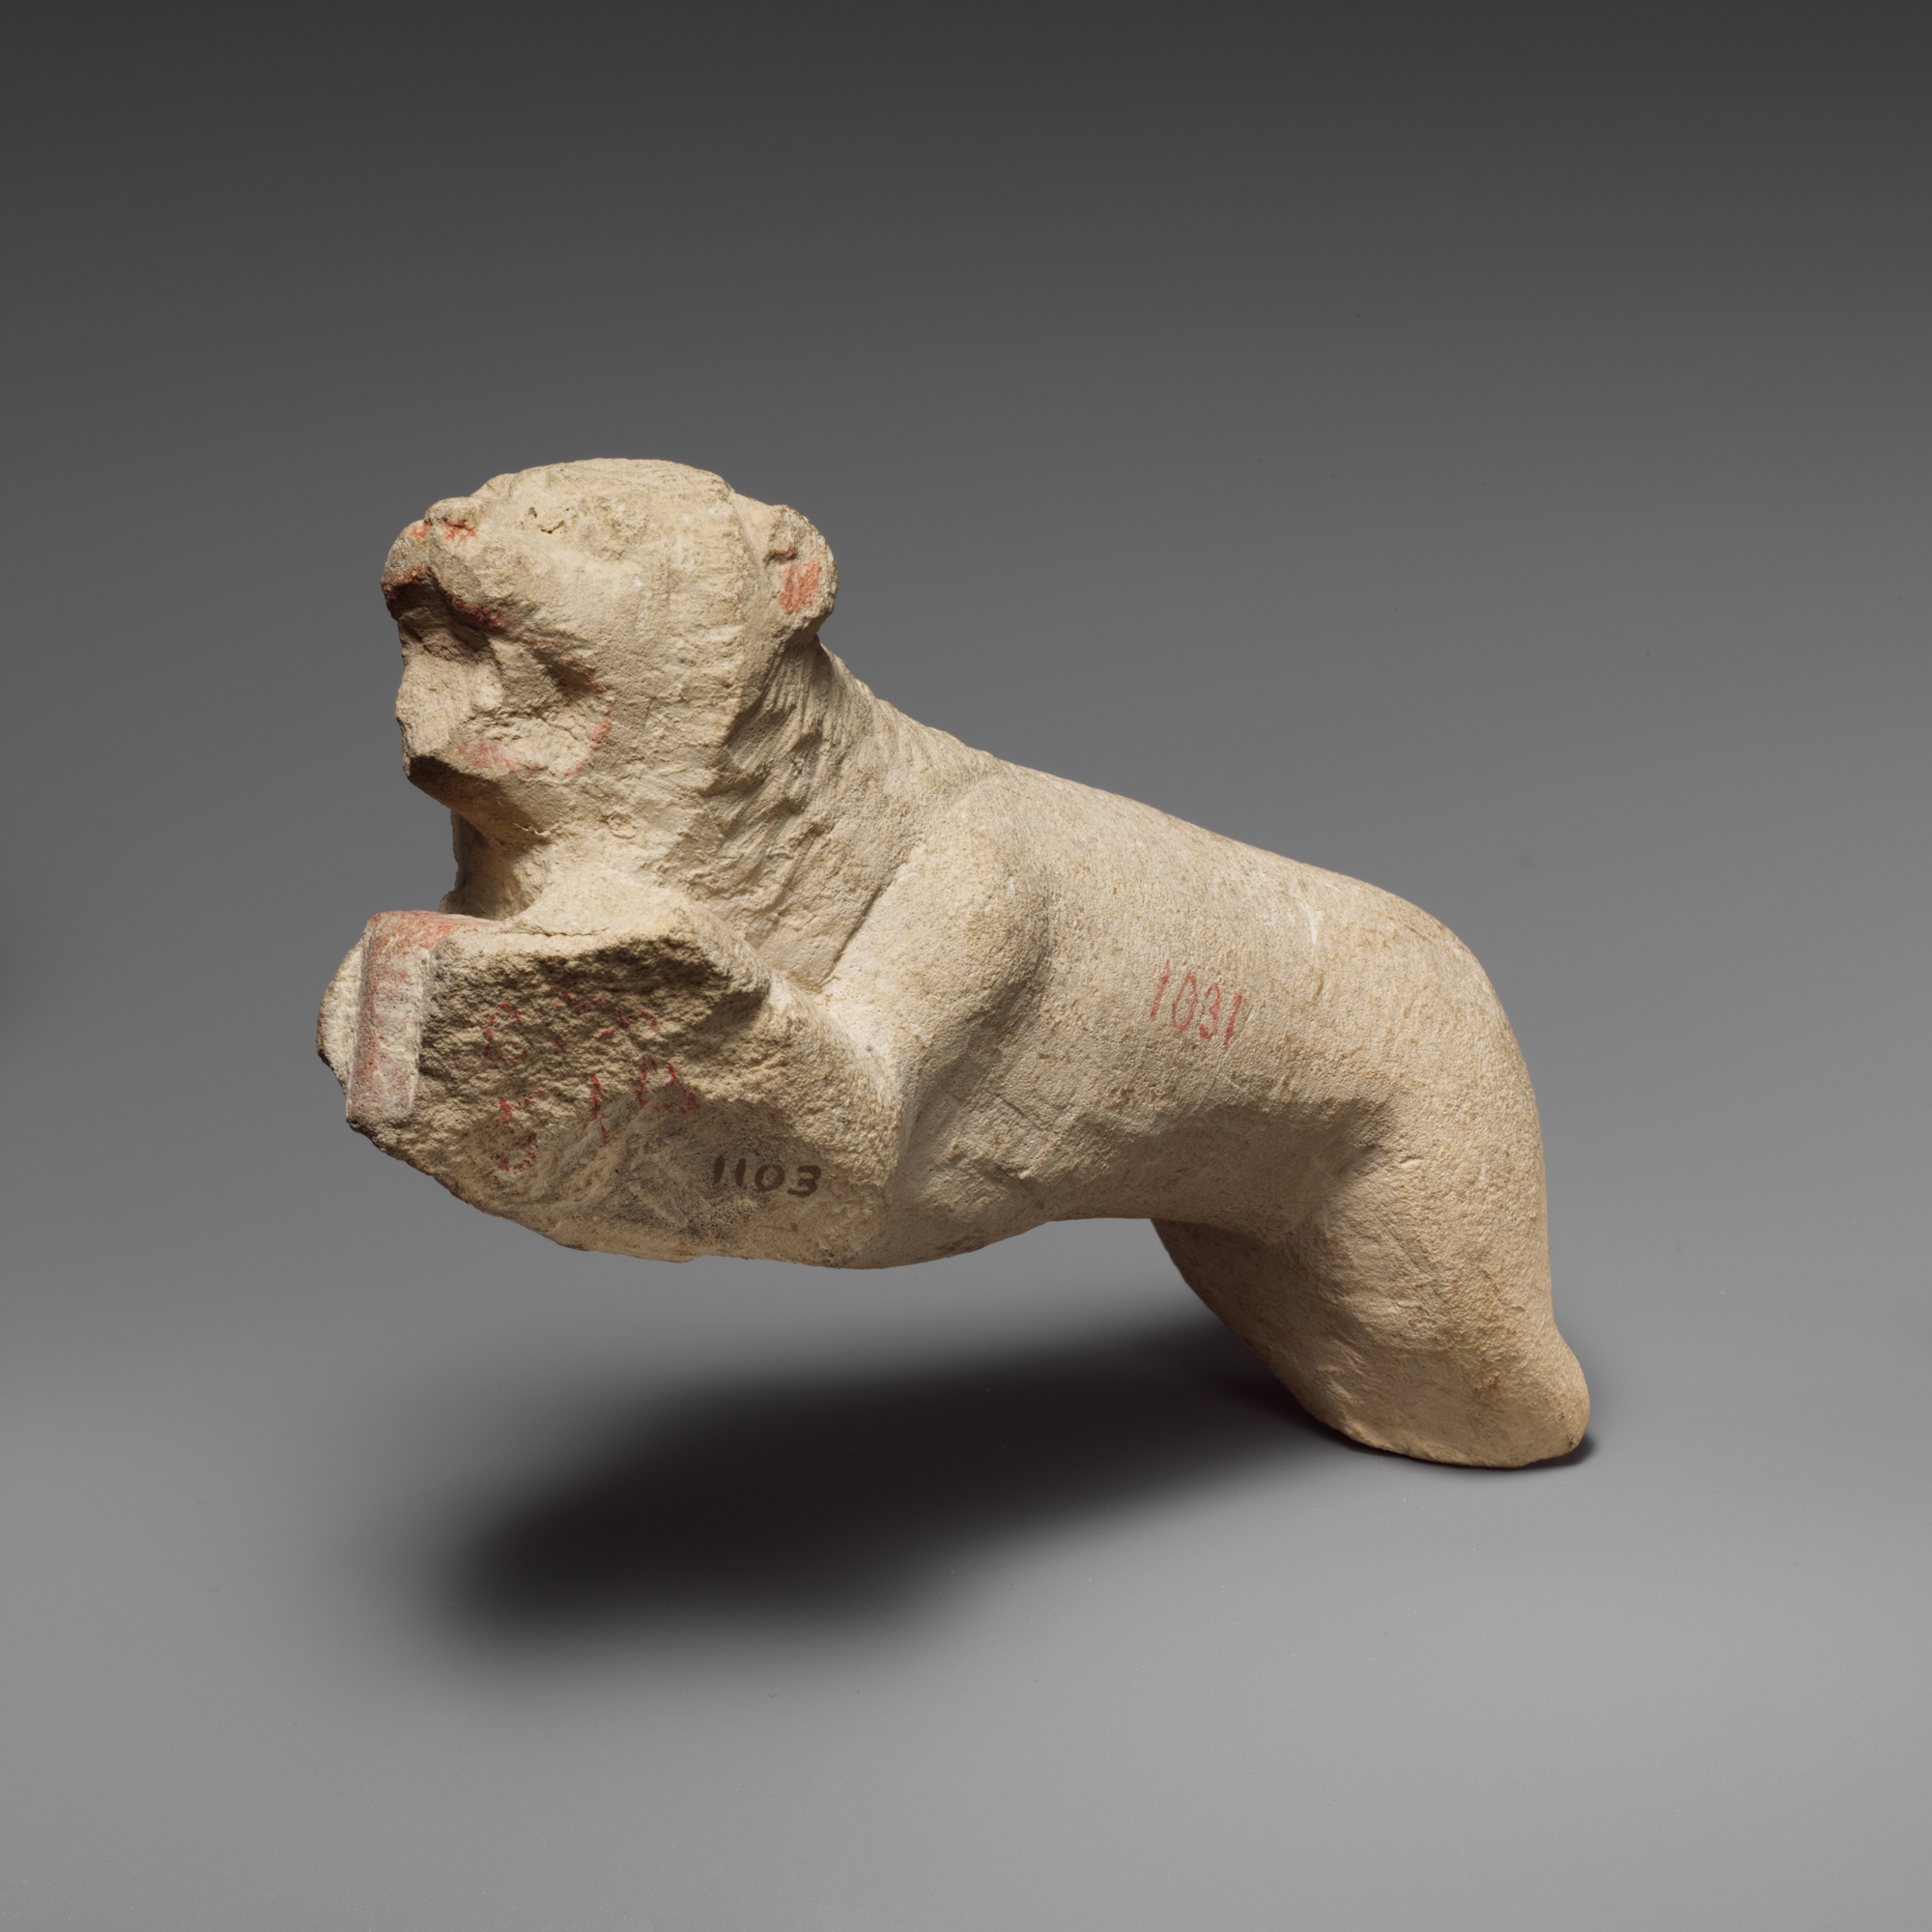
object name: statuette of a lion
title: Limestone lion from a statue of Herakles (?)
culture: cypriot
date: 500-401 BCE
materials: limestone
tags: lions